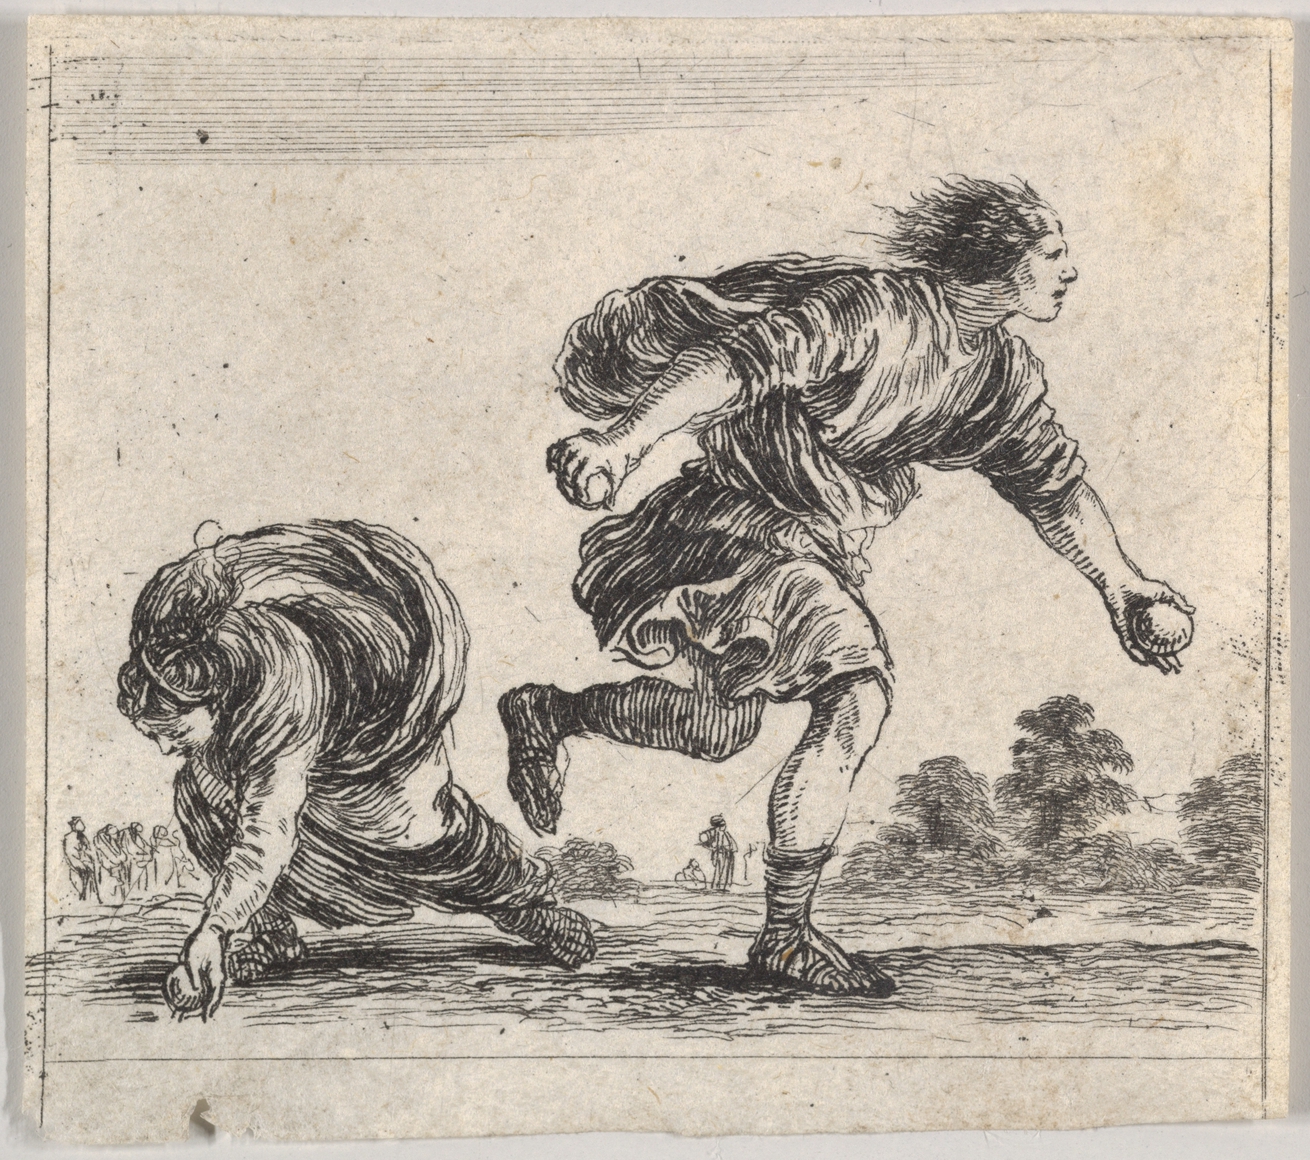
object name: print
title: Atalanta and Hippomenes, from "Game of Mythology" (Jeu de la Mythologie)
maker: stefano della bella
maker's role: artist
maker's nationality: italian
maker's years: 1610-1664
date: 1644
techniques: etching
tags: apples,men,women,running